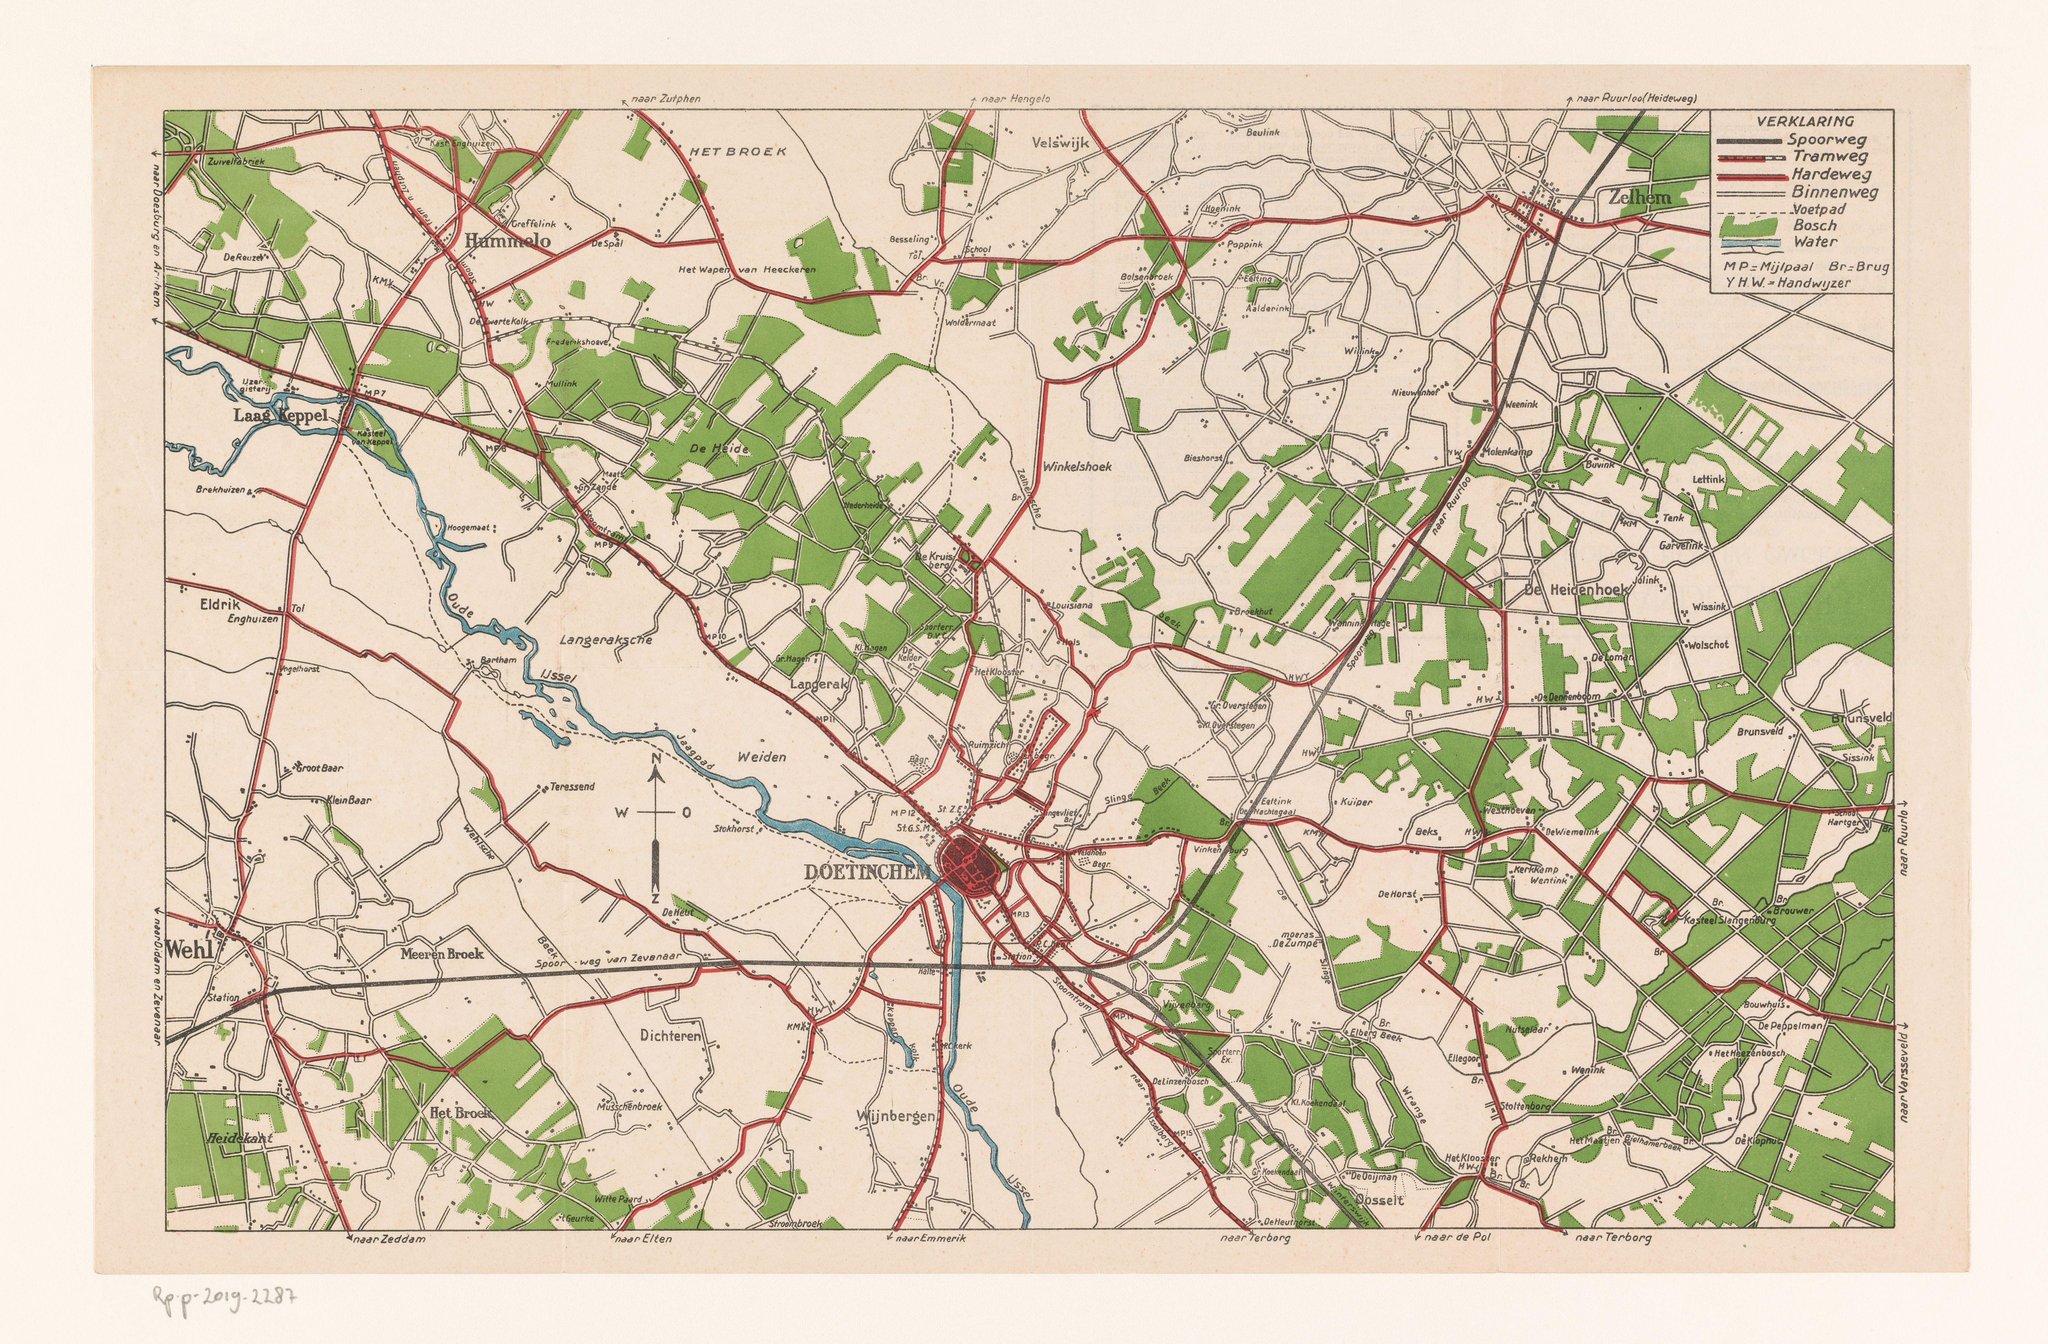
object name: map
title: Wandelkaart van Doetinchem en omgeving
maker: Anonymous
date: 1926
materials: paper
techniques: lithograph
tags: maps of separate countries or regions, gelderland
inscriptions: collector's mark: Lugt 2228